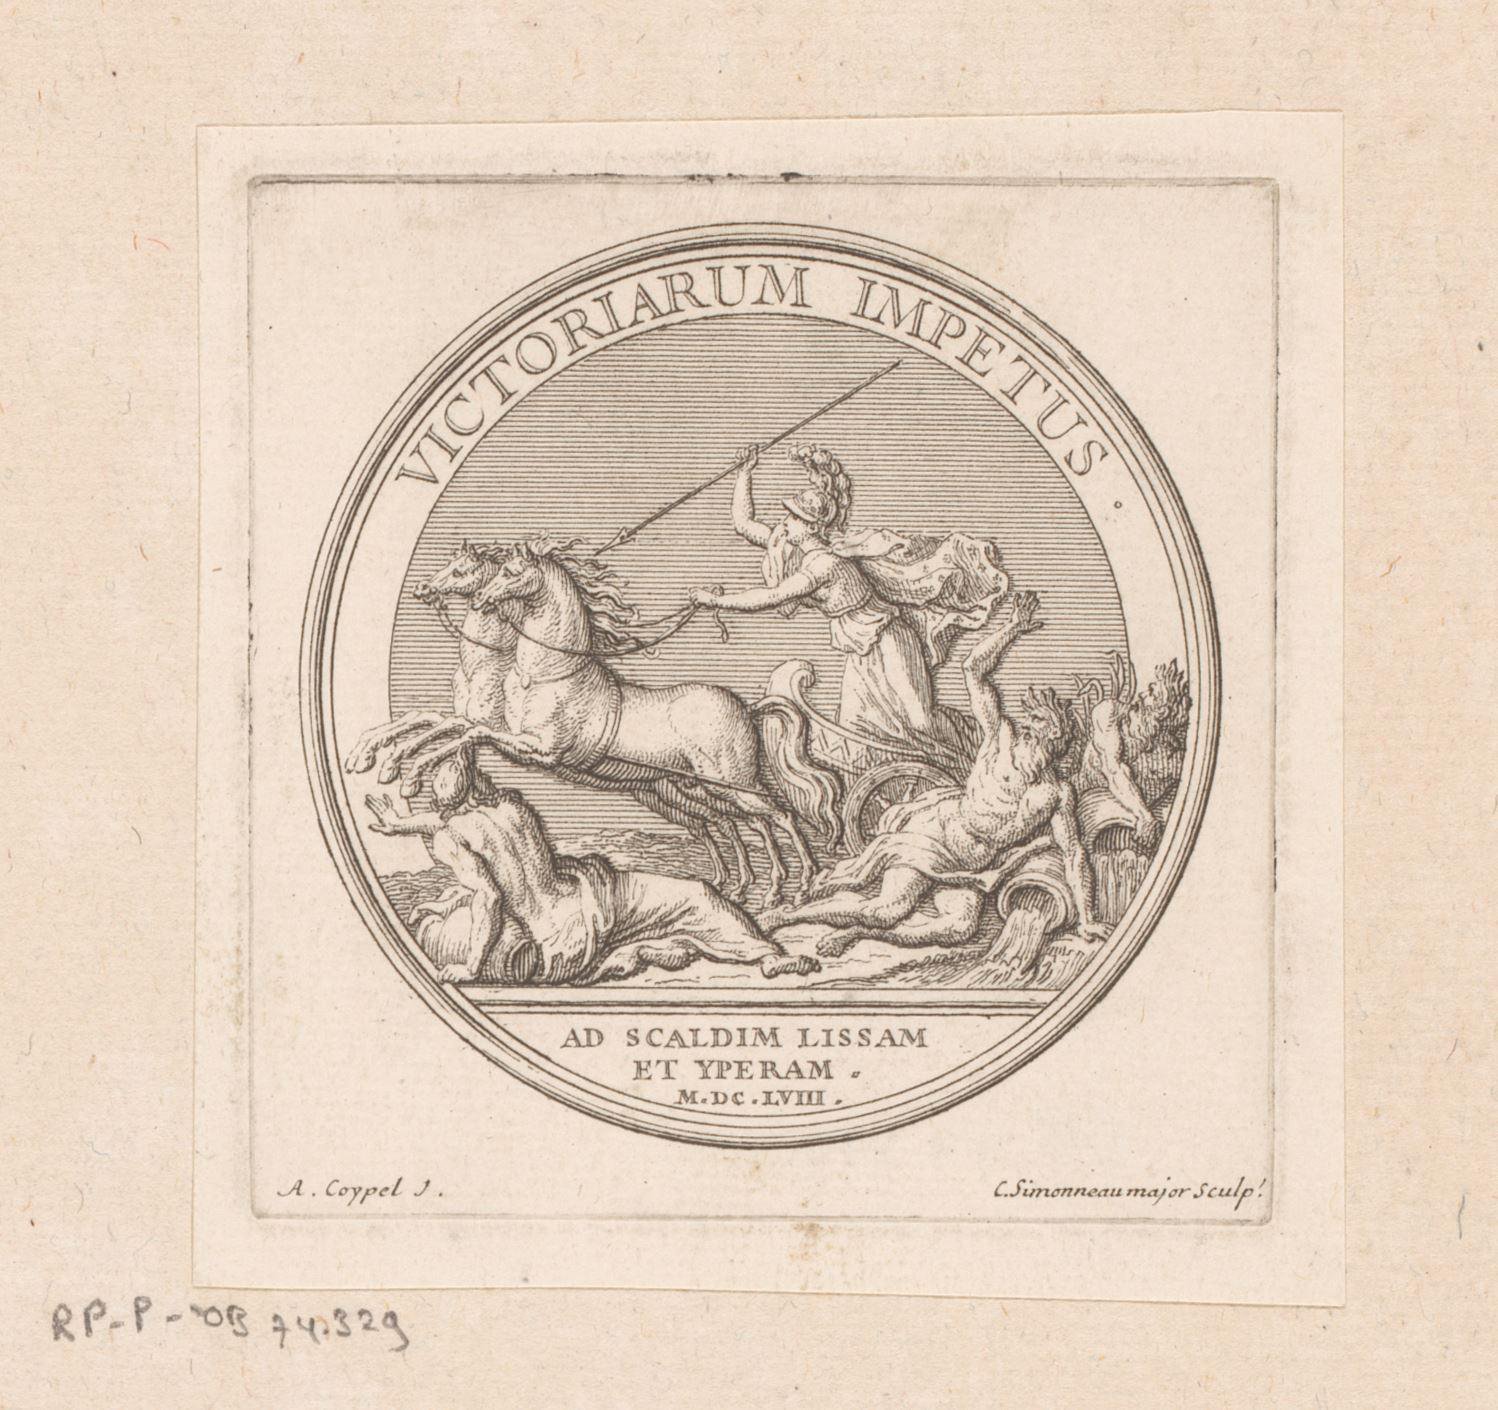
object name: print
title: Vrouwelijke figuur op strijdwagen geleid door twee paarden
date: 1723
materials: paper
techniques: engraving, etching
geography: paris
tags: lodewijk xiv (koning van frankrijk), river, 'victoria'; 'vittoria', 'vittoria navale', 'vittoria degl'antichi' (ripa)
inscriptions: collector's mark: Lugt 240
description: Prent uit: Académie des inscriptions et belles-lettres. Medailles sur les principaux evenements du regne entier de Louis de Grand, avec des explications historiques. Parijs: Imprimerie Royale, 1723.